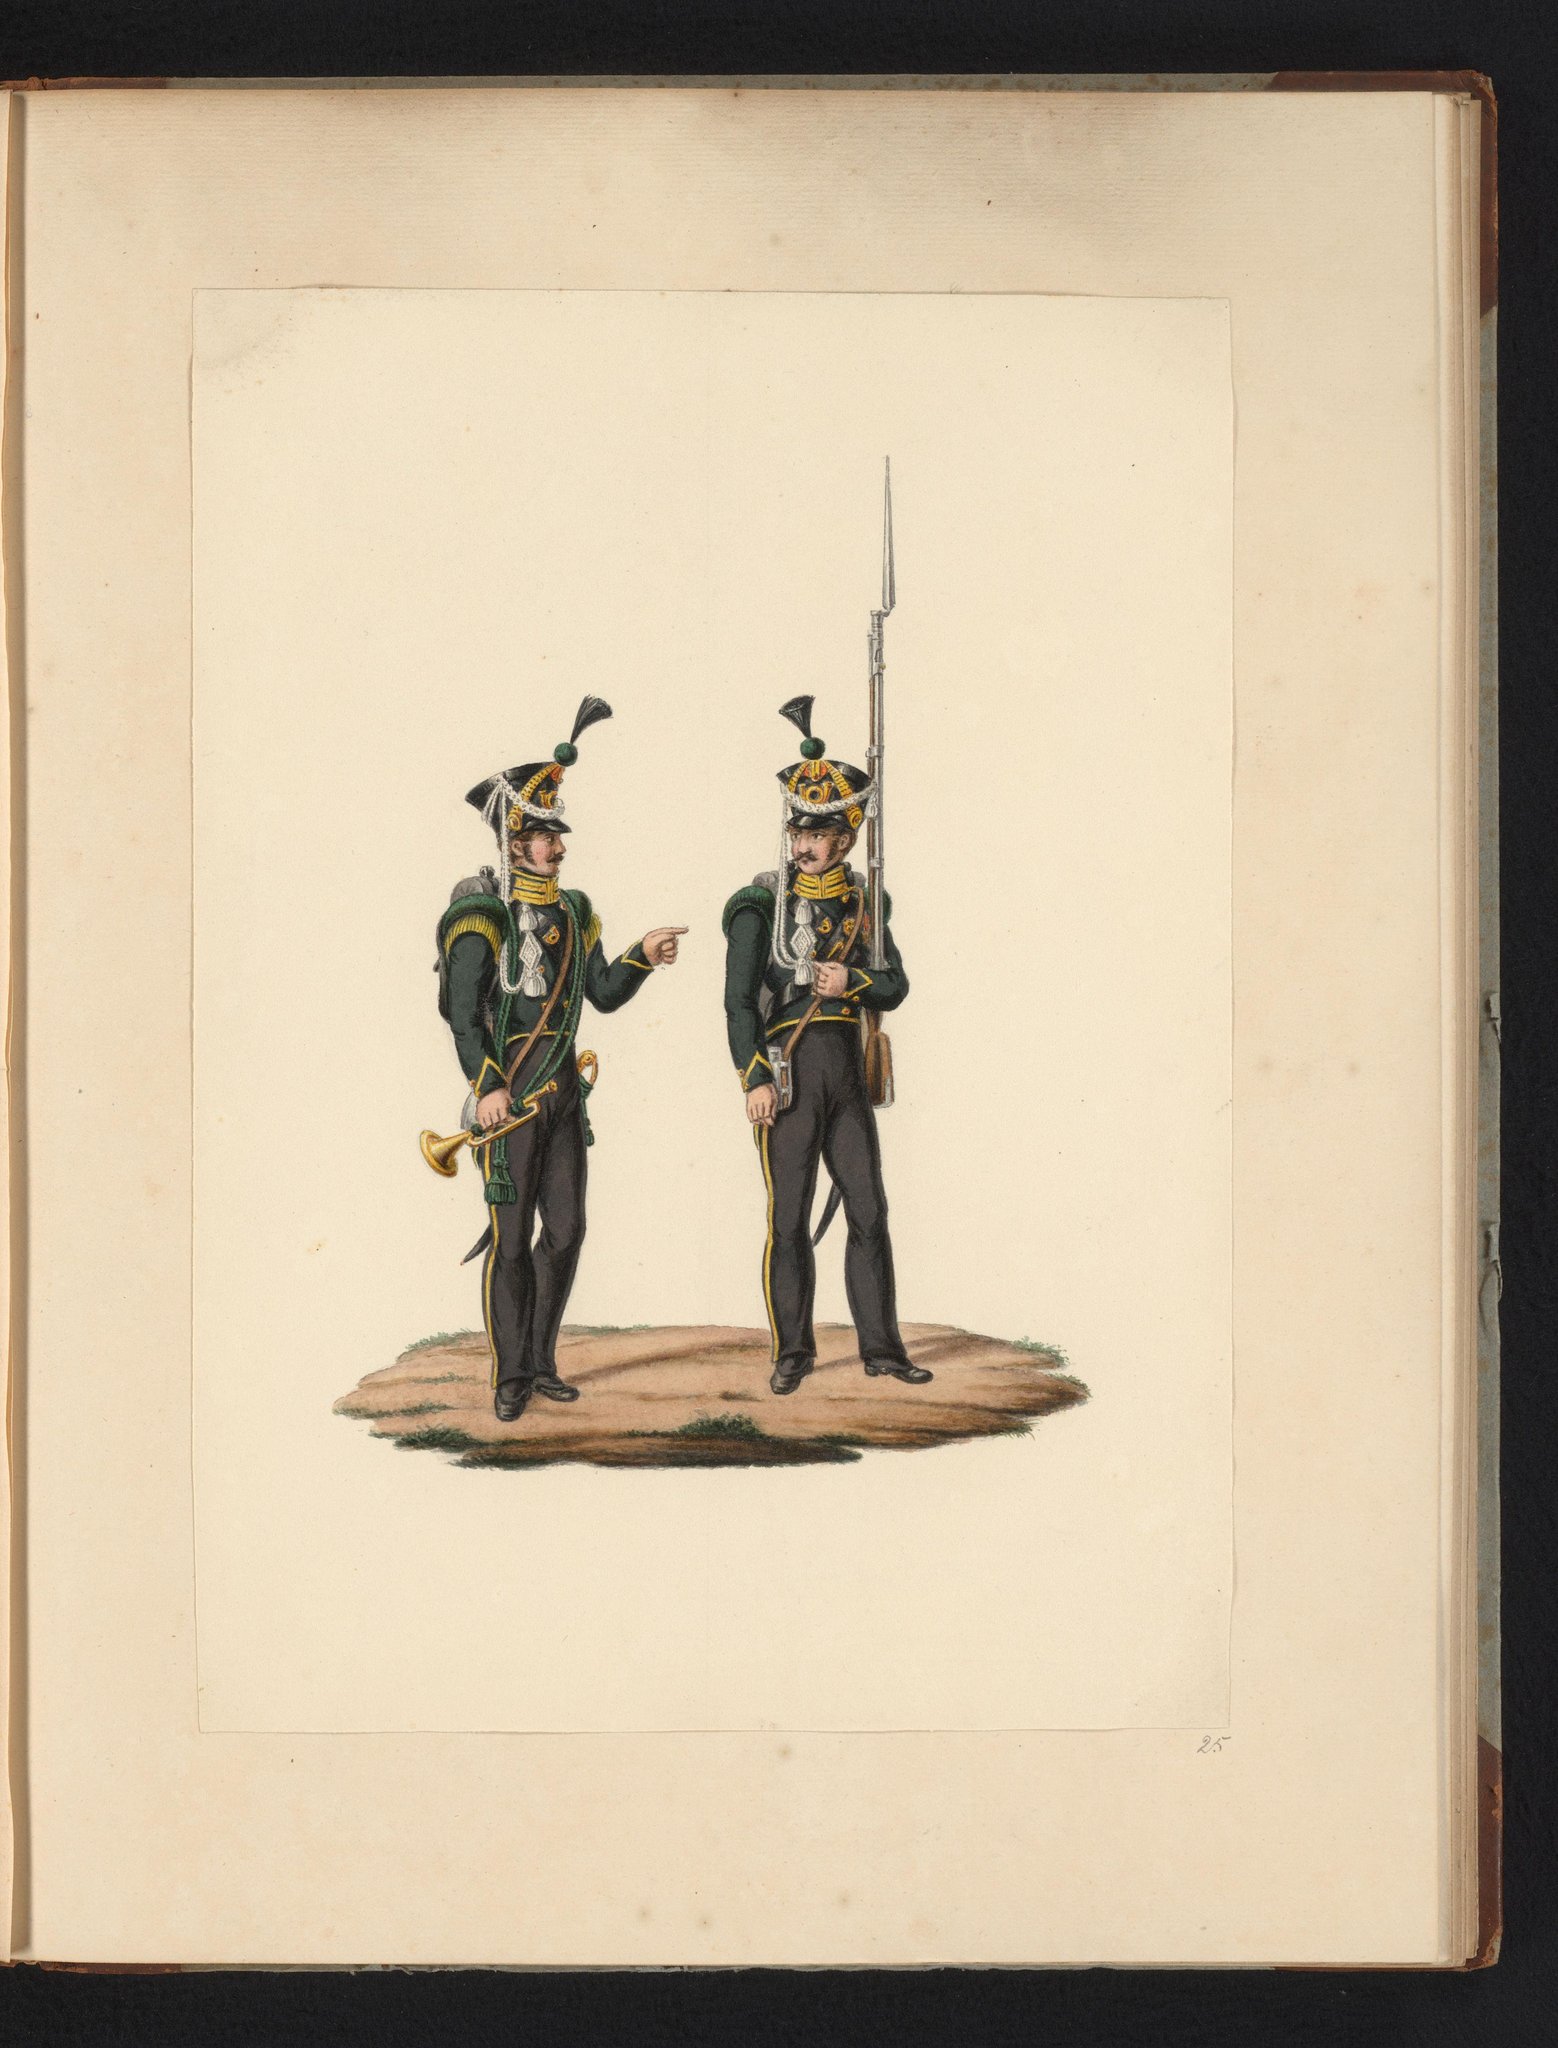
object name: costume print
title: Trompetter en jager van de jagers, 1830-1831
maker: Anonymous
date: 1831-1832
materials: paper, pencil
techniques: brush, lacquer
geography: netherlands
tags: professional clothes, (military) uniforms, netherlands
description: Een trompetter en een jager van de jagers, te voet. Onderdeel van het album met 39 ingeplakte tekeningen van militairen van de Koninklijke Nederlandsche Armee uit 1830-1831.